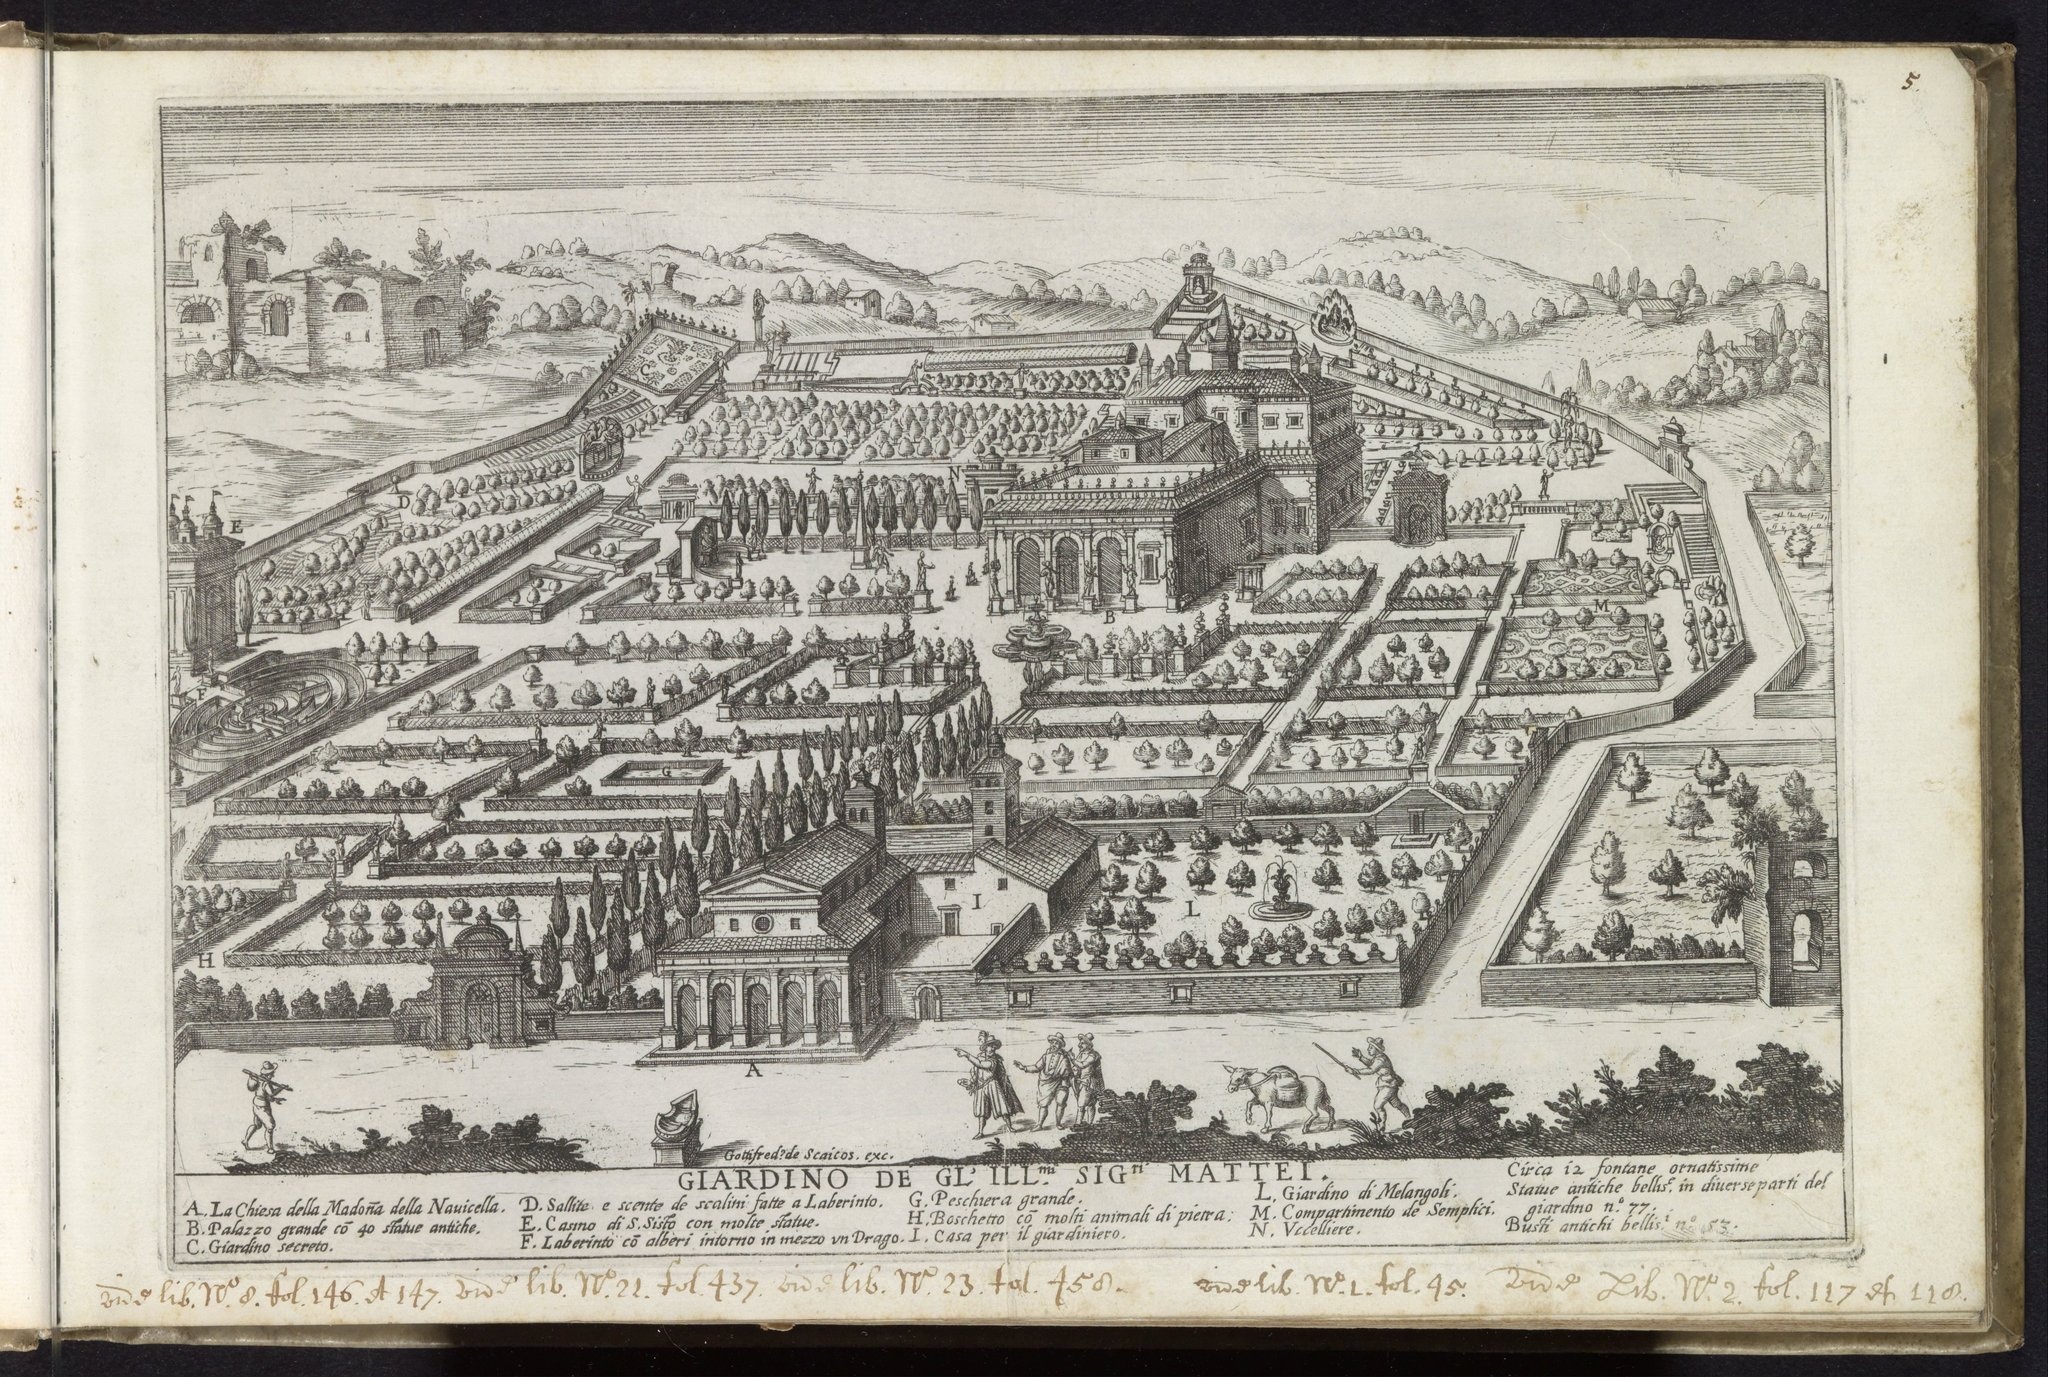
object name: album leaf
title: Villa's en tuinen in Rome en Tivoli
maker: govert van schayck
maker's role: publisher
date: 1623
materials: paper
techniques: engraving, etching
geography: rome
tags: garden, hôtel, i.e. small palace in city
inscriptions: inscription: ‘Ende lib. No. 8. fol. 146. et 147. Ende lib. No. 21. fol. 437. Ende lib. No. 23. fol. 458./ Ende lib. No. 1. fol. 45. Ende lib. No. 2. fol. 117 et 118.’, number: ‘5’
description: Gezicht op Villa Celimontana (van de familie Mattei) en tuin te Rome. In de ondermarge de titel in het Italiaans en een verklarende lijst met letters. Prent maakt deel uit van een album.